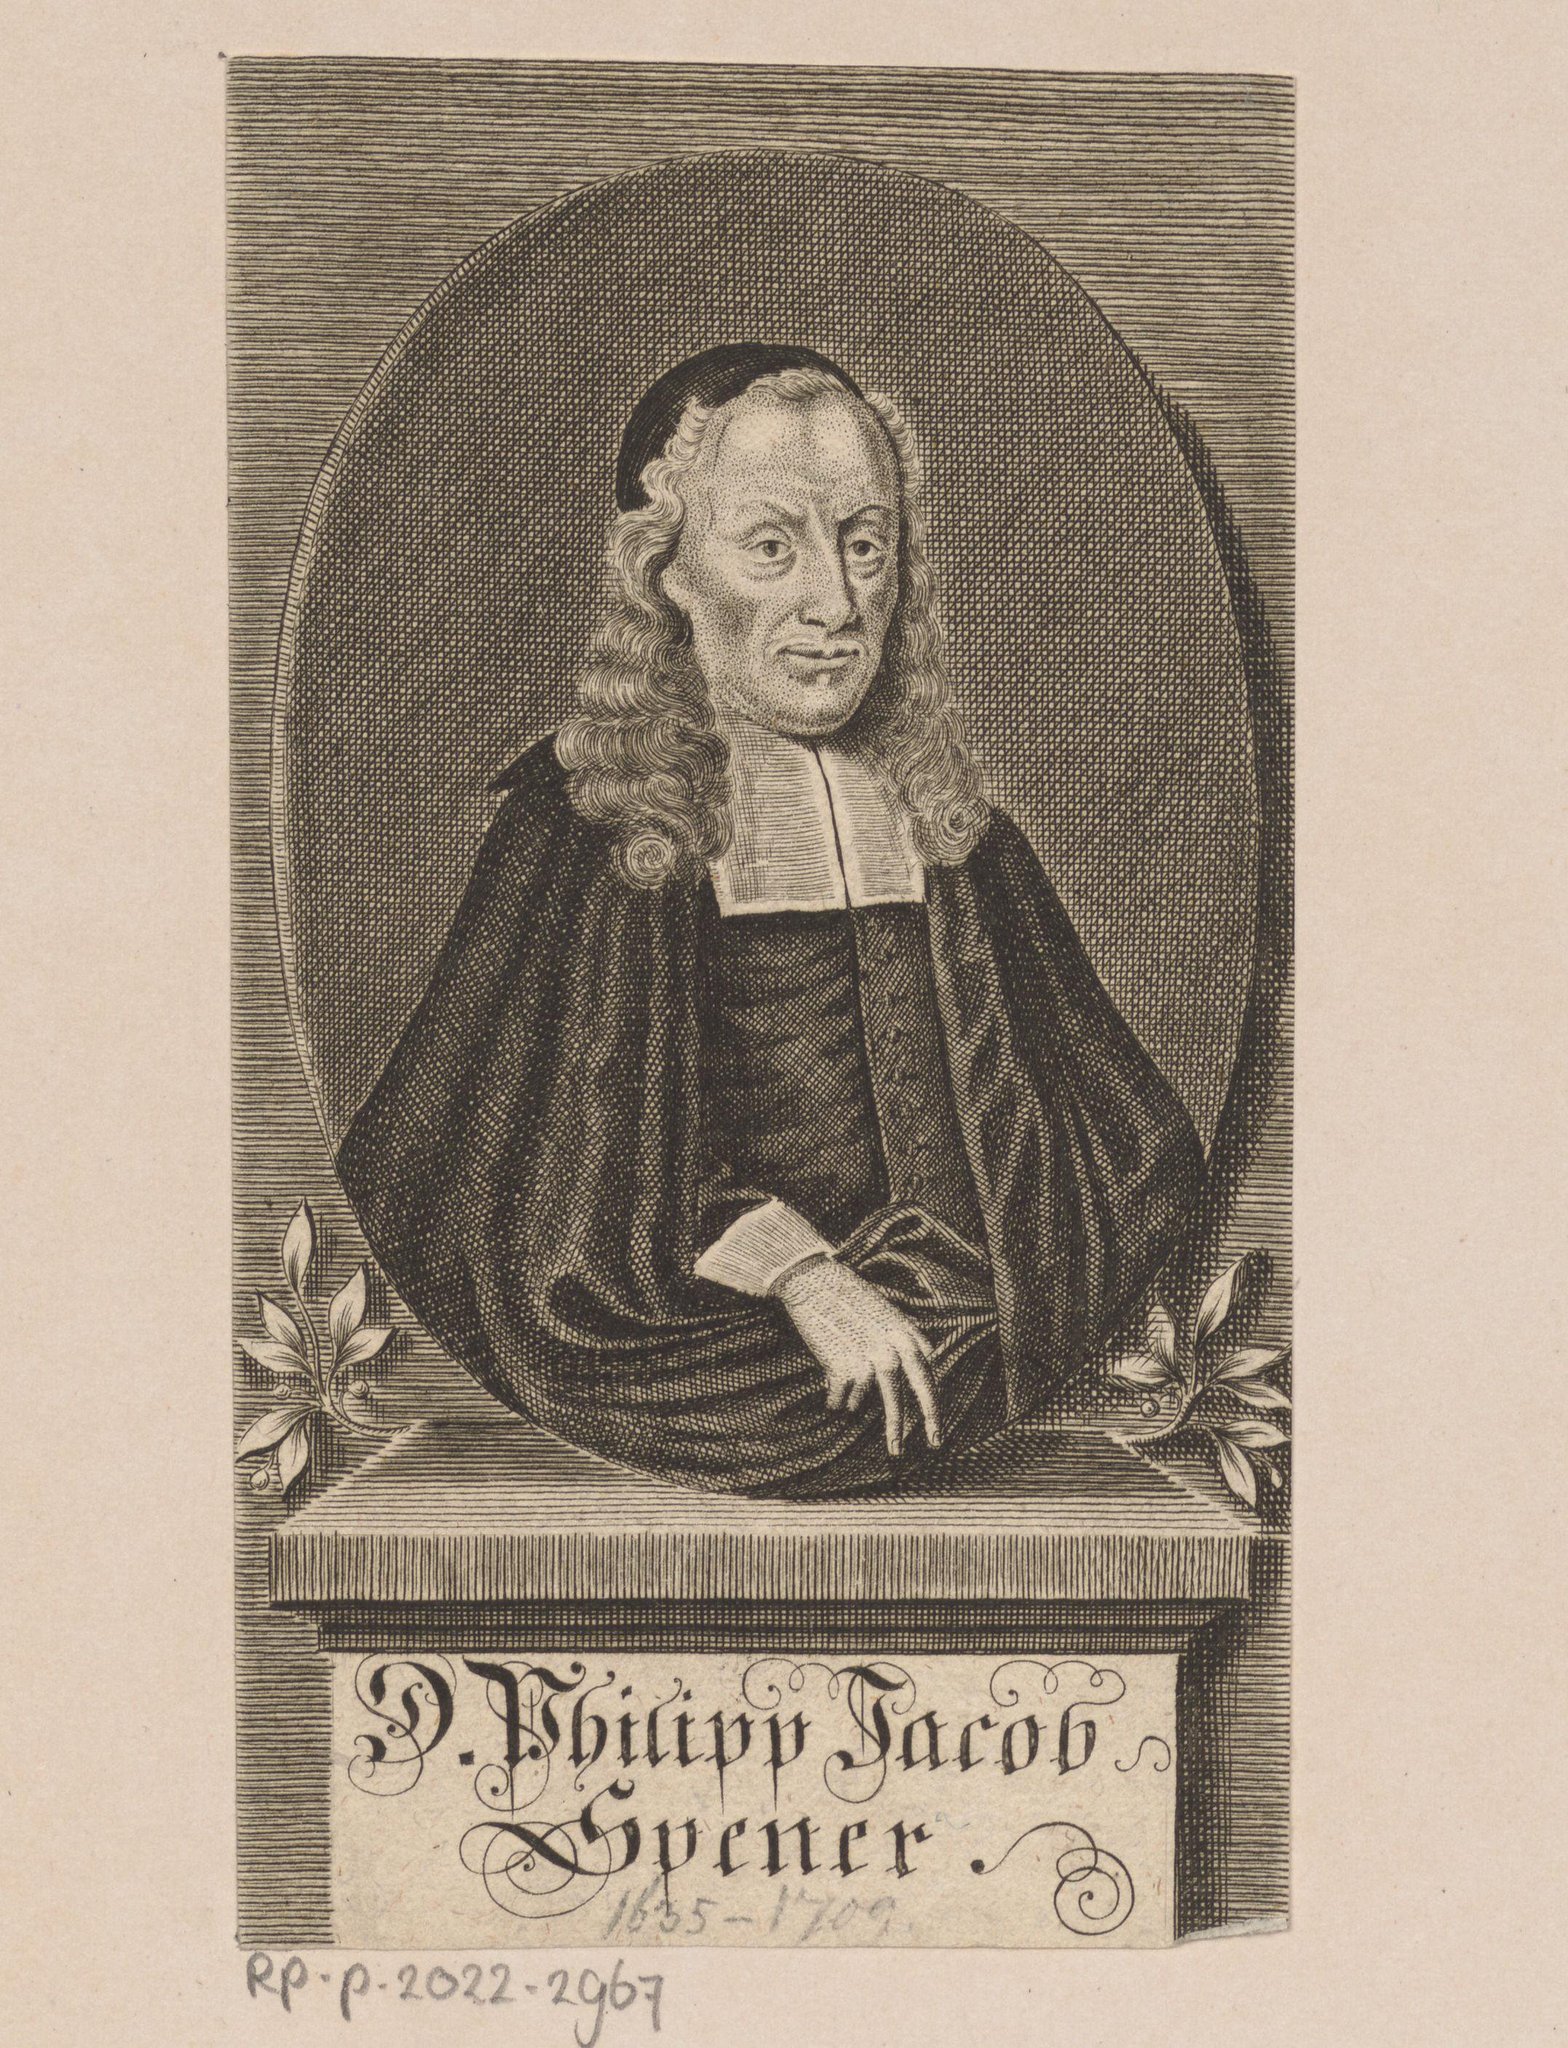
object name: print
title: Portret van Philipp Jacob Spener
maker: Anonymous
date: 1675-1799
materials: paper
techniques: engraving, etching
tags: berlin, philipp jacob spener, theologian, historical persons